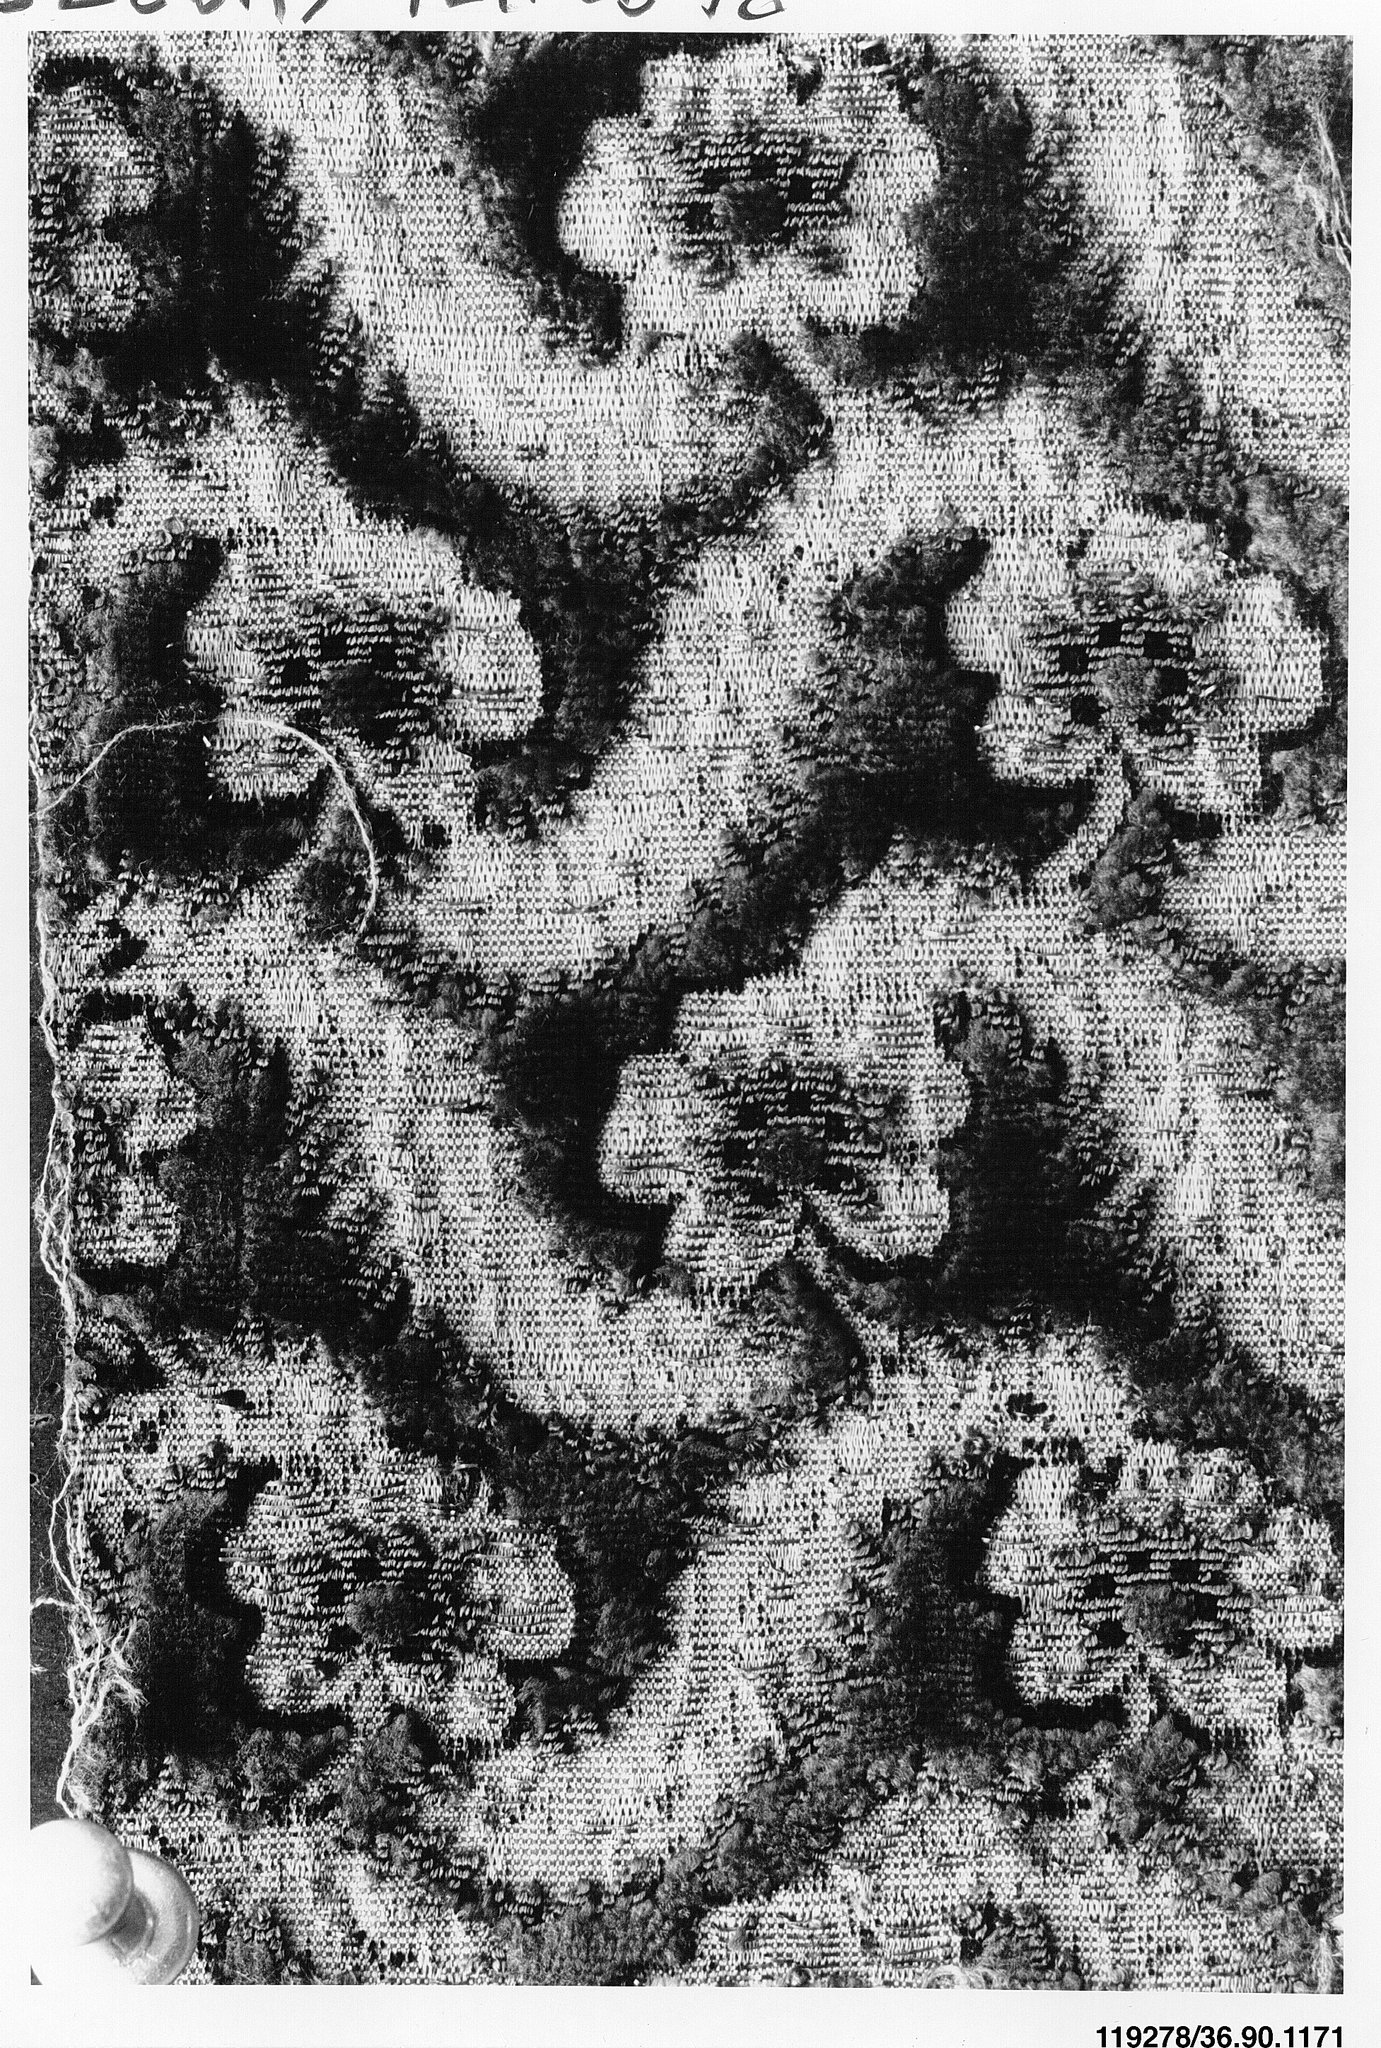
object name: piece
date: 1701-1800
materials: metal thread, silk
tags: flowers